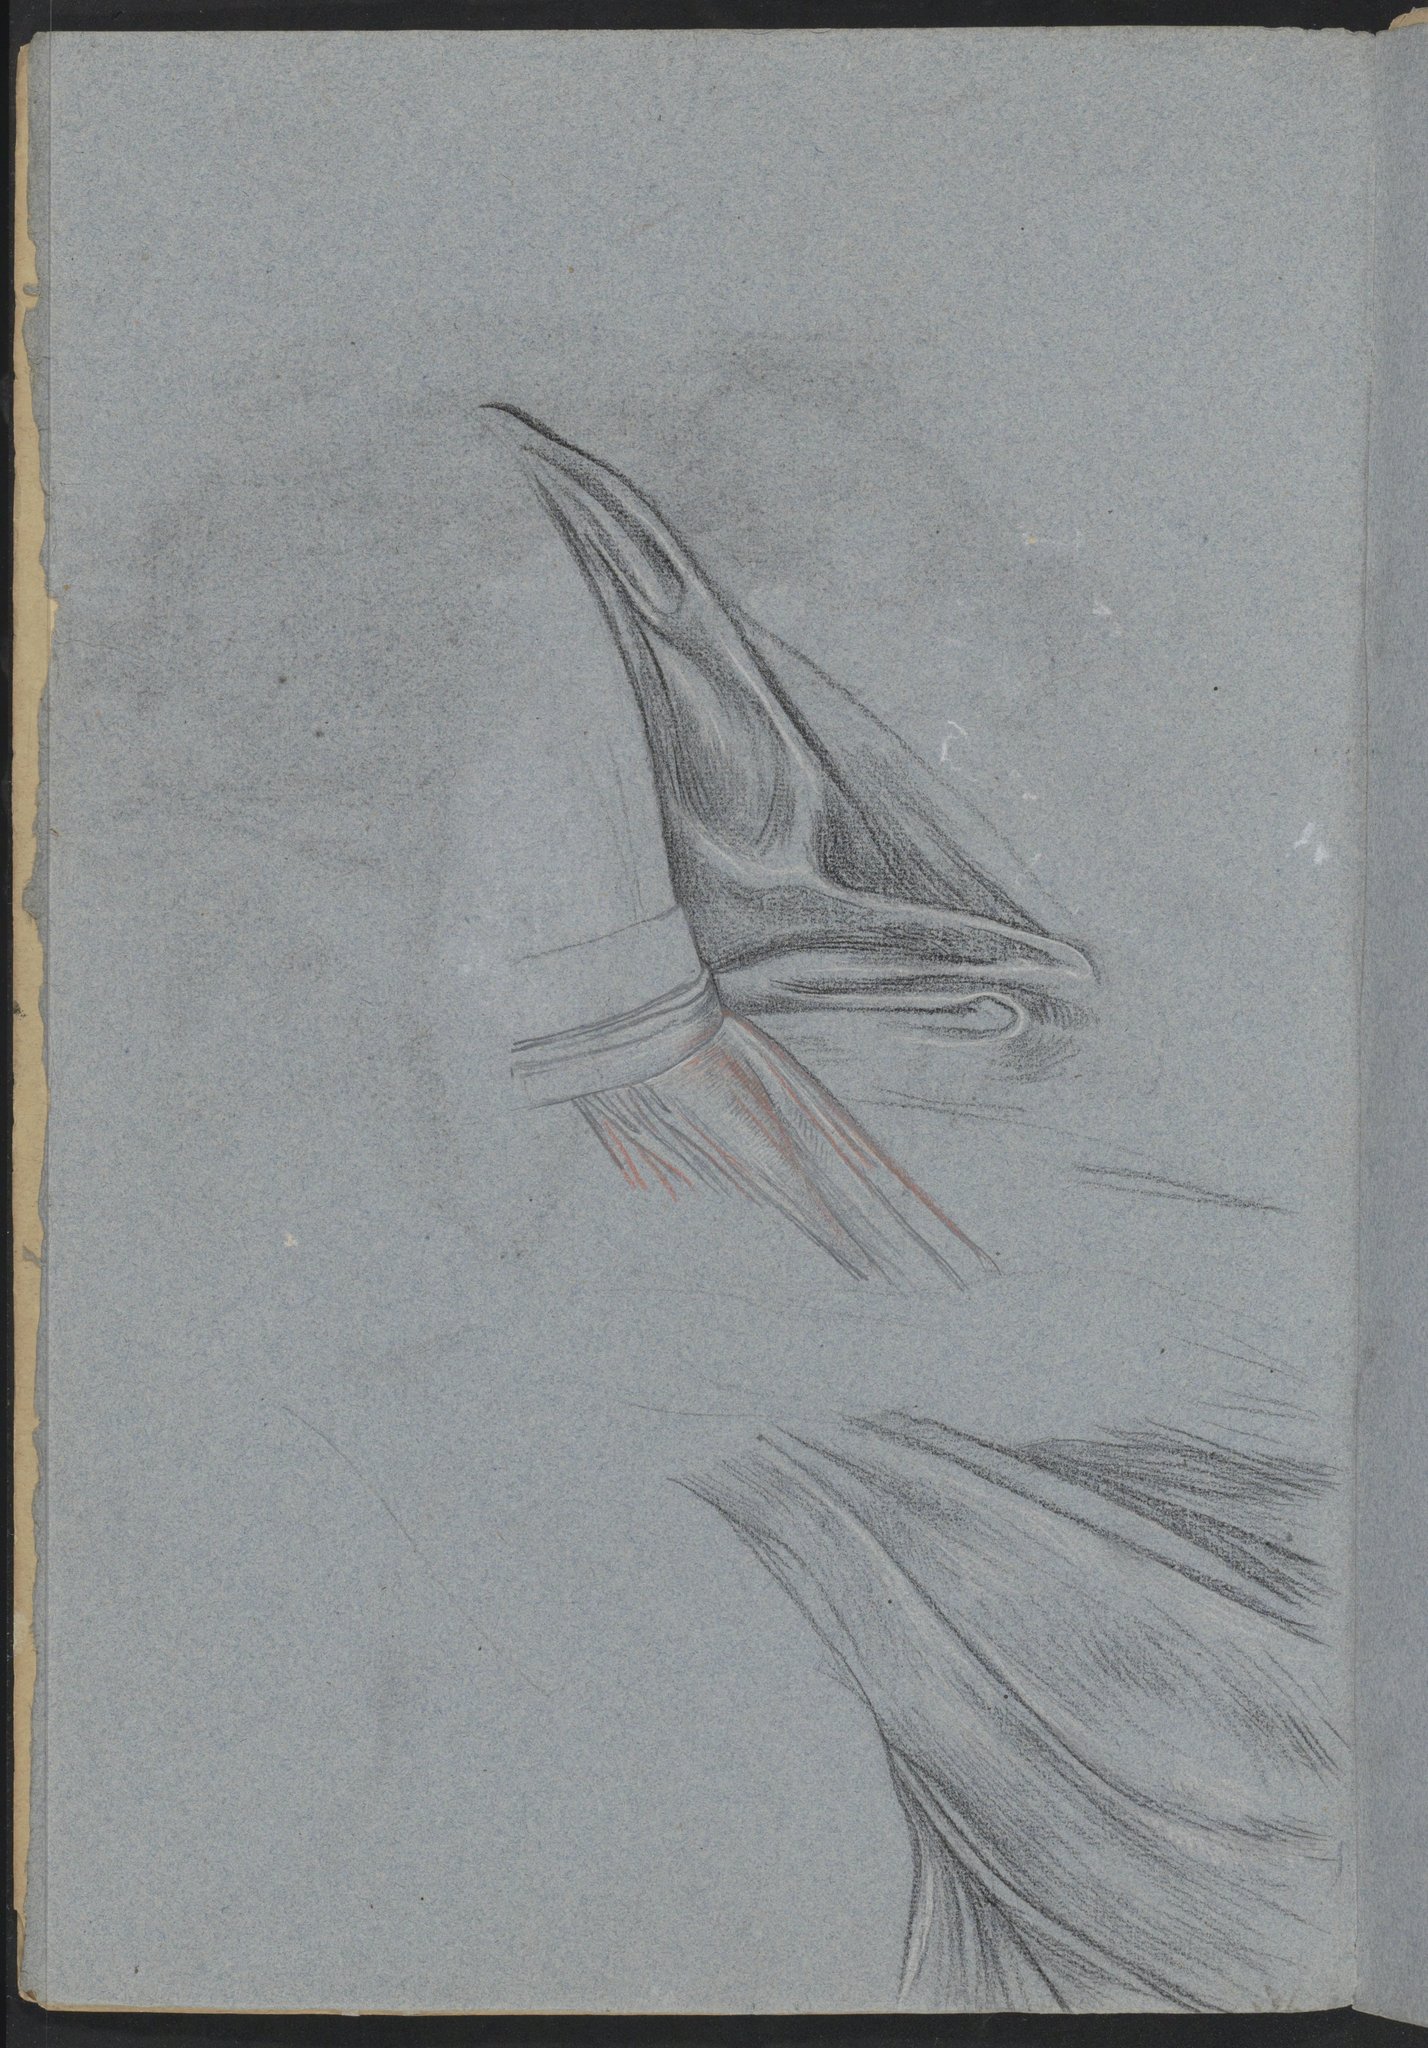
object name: sketchbook leaf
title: Jurk en onderarm van een zittende vrouw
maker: jan veth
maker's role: designer, draughtsman, painter, print maker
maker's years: 1864-1925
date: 1874-1925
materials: chalk, paper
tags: lower arm, dress, gown (+ women's clothes)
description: Blad 2 verso uit een schetsboek met 42 bladen.